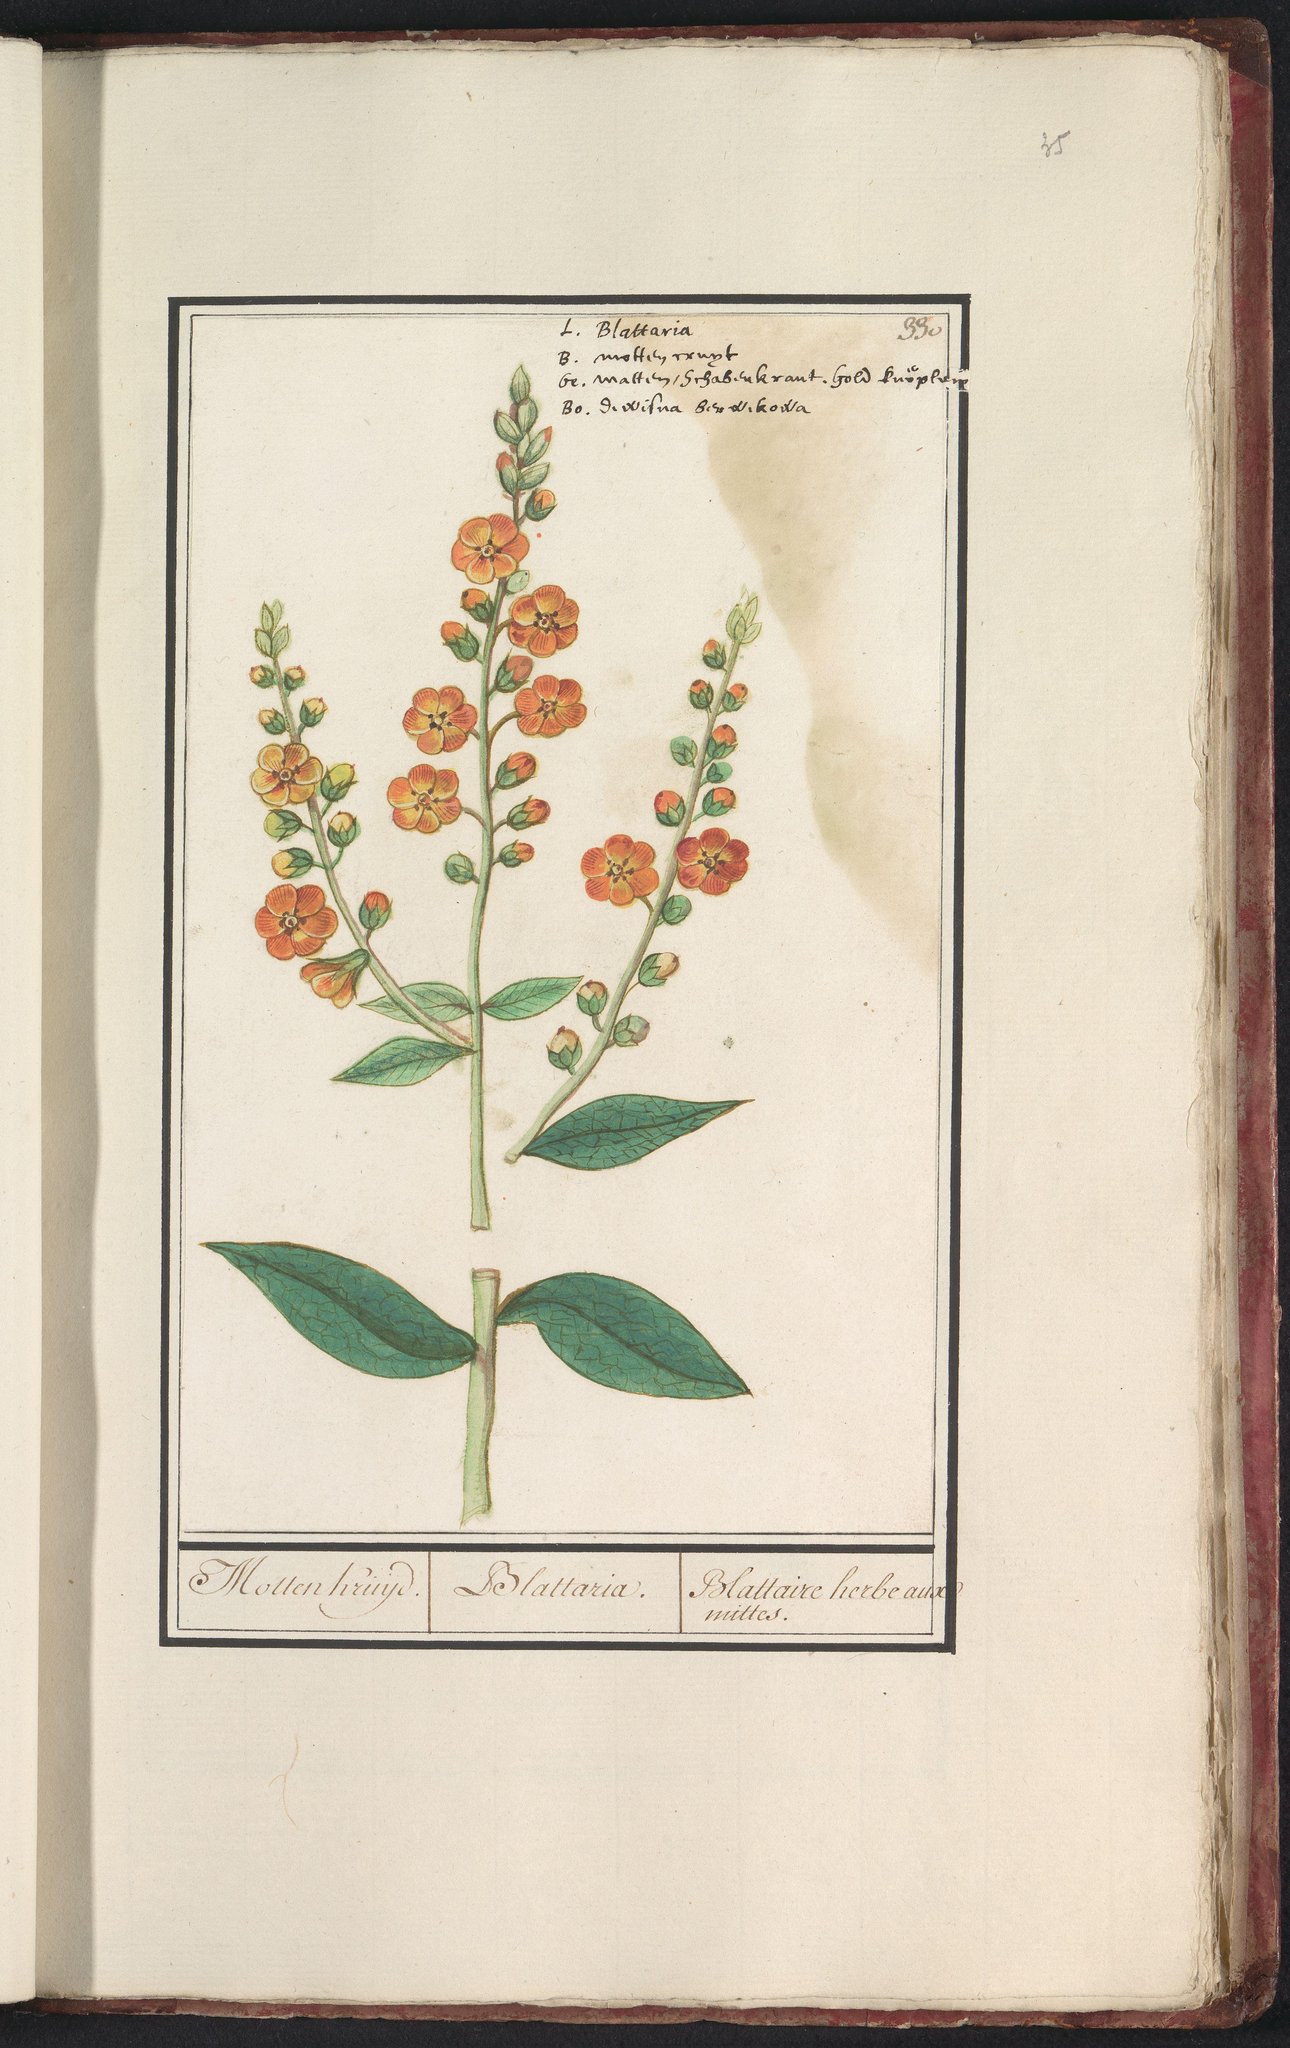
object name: drawing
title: Motten Kruijd. / Blattaria. / Blattaire herbe aux mittes.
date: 1596-1610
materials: chalk, paint, ink, paper, watercolor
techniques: brush, pen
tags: flowers: moth mullein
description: Mottenkruid. Genummerd rechtsboven: 330. Hierbij ook de naam in vier talen. Onderdeel van het vierde album met tekeningen van bloemen en paddestoelen. Elfde van twaalf albums met tekeningen van dieren, vogels en planten bekend rond 1600, gemaakt in opdracht van keizer Rudolf II. Met toelichting in Nederlands, Latijn en Frans.